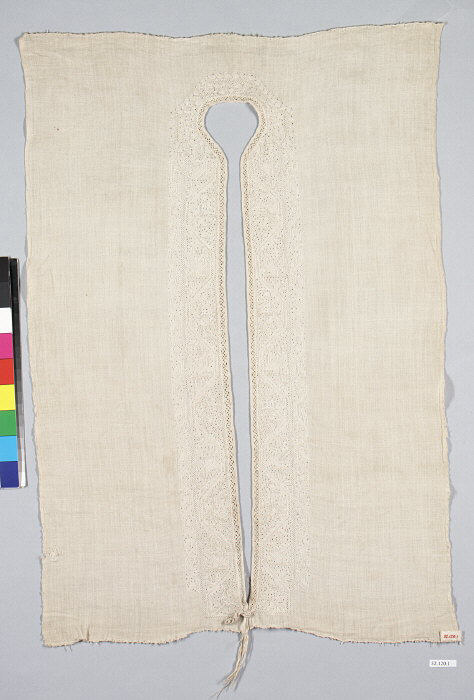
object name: collar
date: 1701-1900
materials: linen